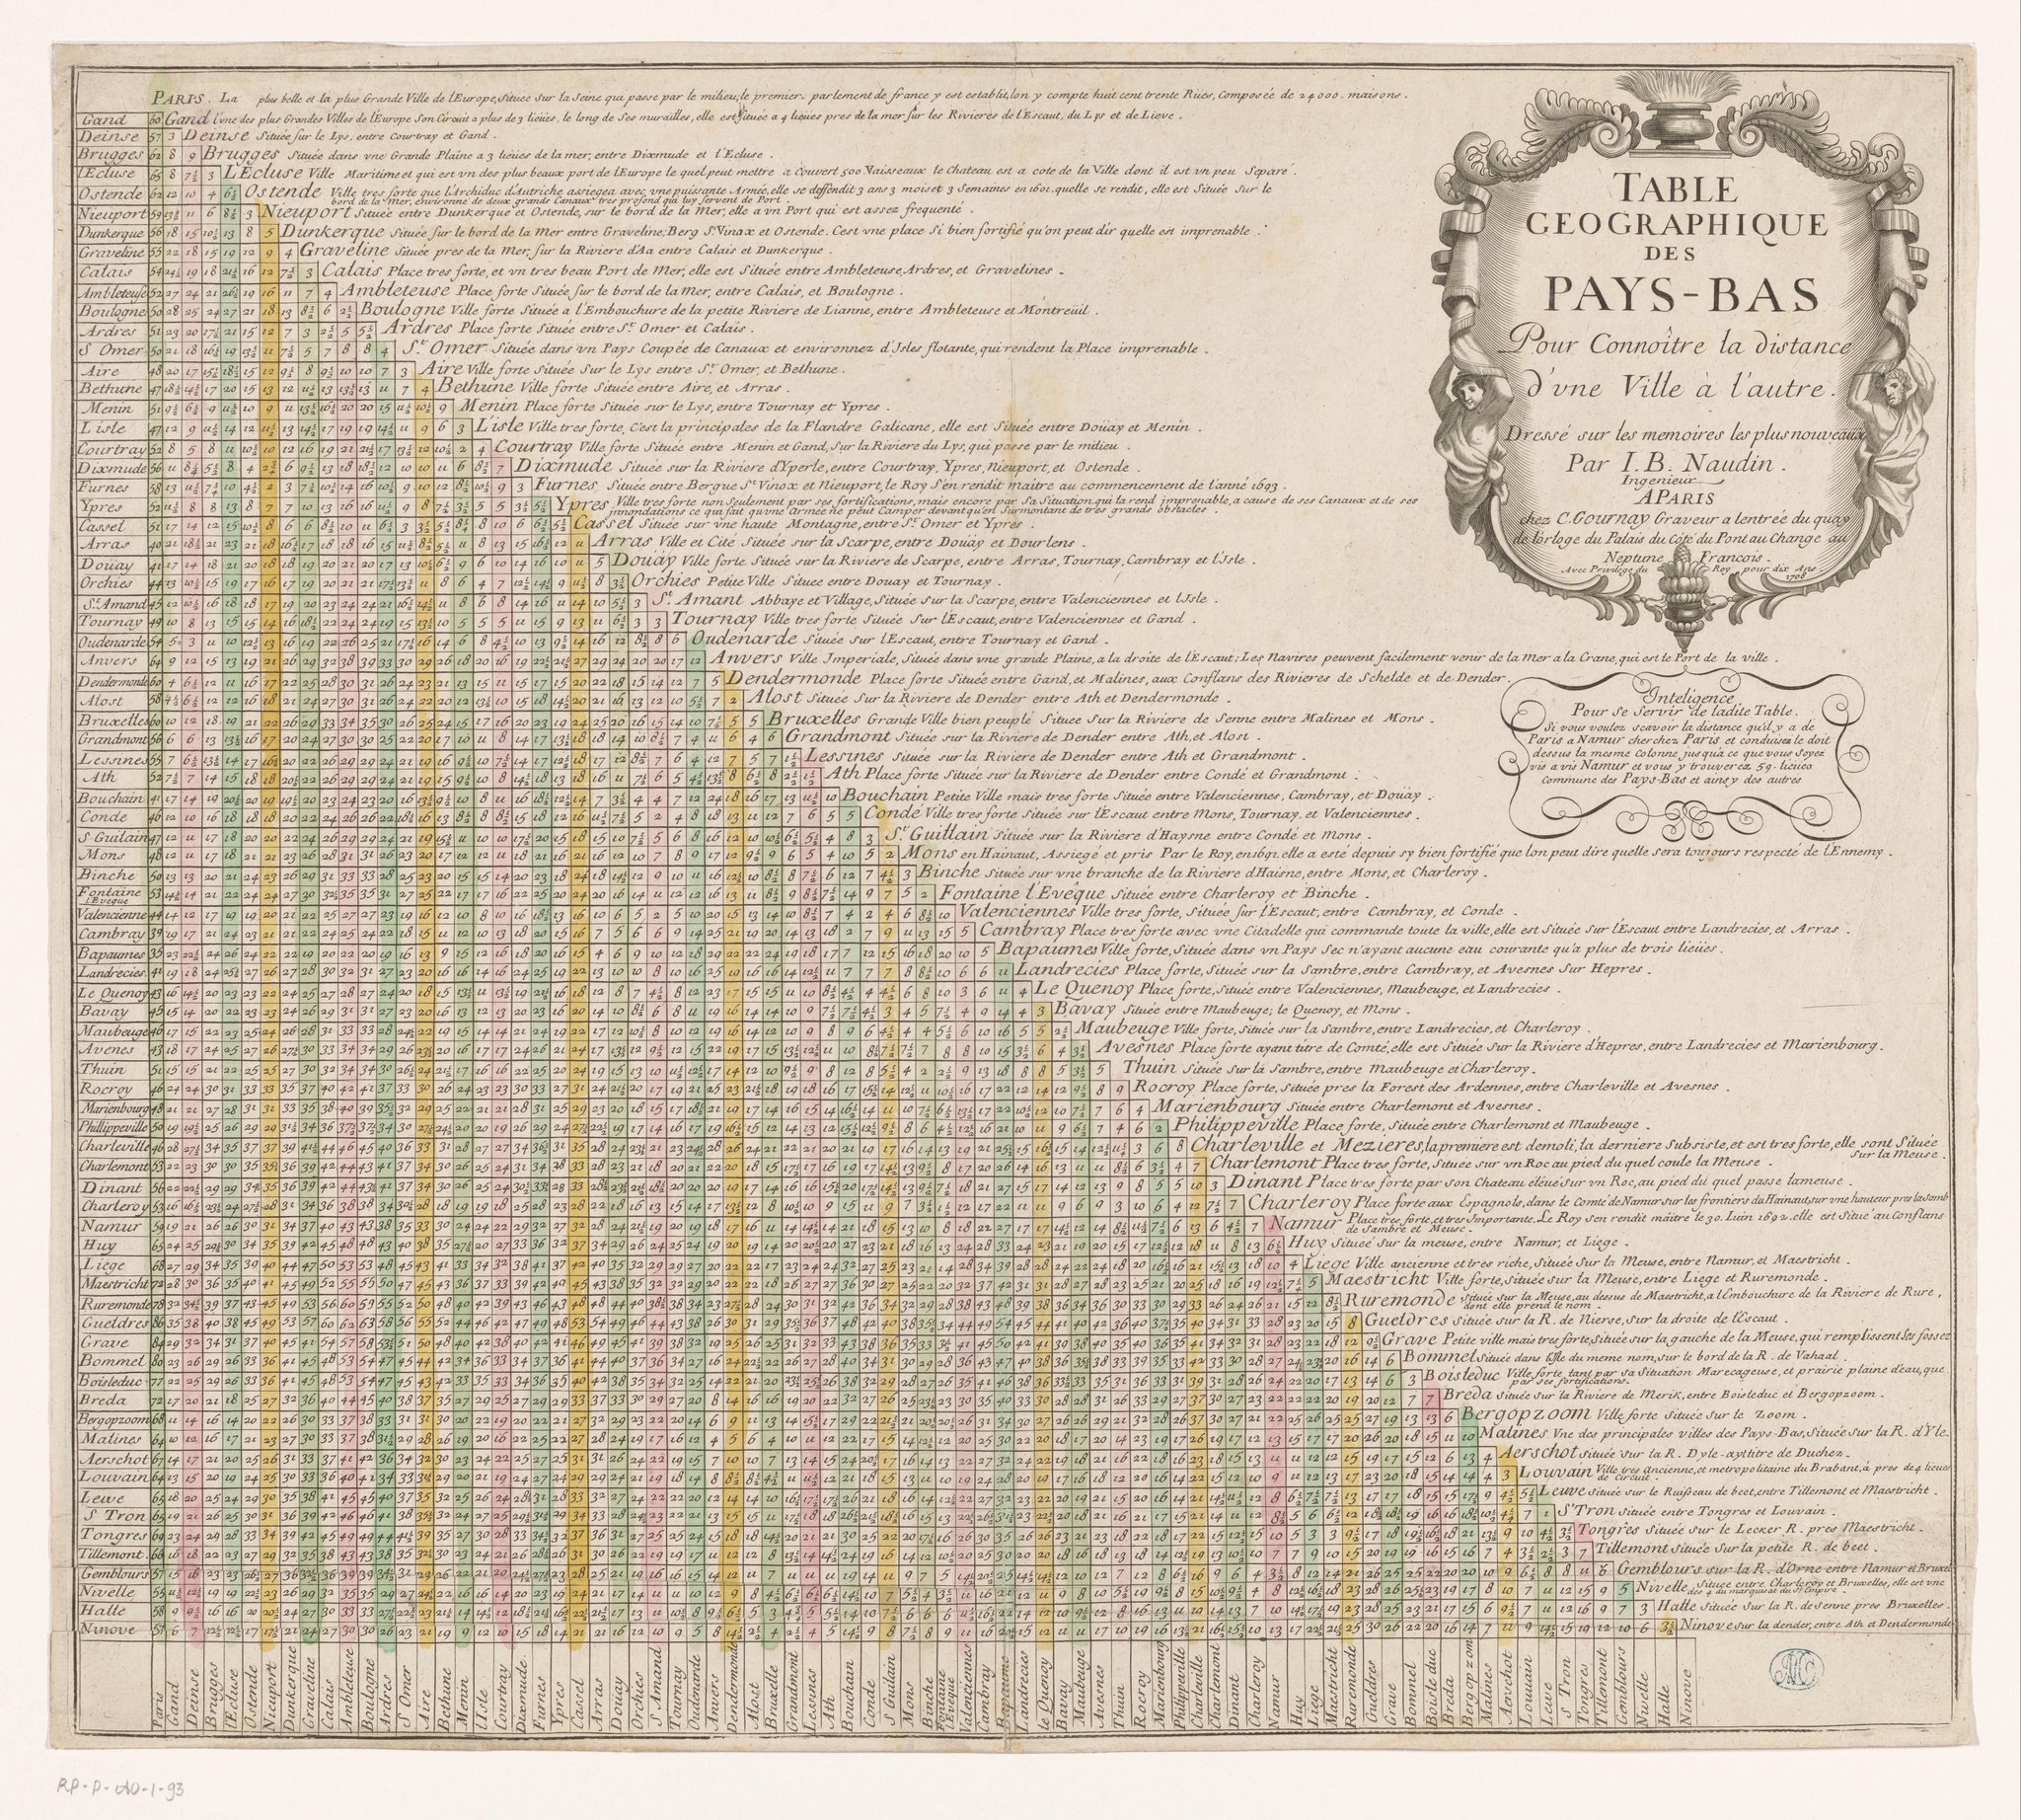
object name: print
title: Table geographique des Pays-Bas pour connoître la distance d'une villa à l'autre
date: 1708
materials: paper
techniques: engraving, hand coloring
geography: paris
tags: netherlands, france, belgium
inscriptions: collector's mark: Lugt 2228, collector's mark: Lugt 195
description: Links een afstandstabel waarin staat hoeveel loopuren belangrijke steden uit Staats-Brabant, de Zuidelijke Nederlanden, Noord-Frankrijk en Parijs van elkaar vandaan liggen. Rechts de titelcartouche met daaronder een gebruiksaanwijzing.